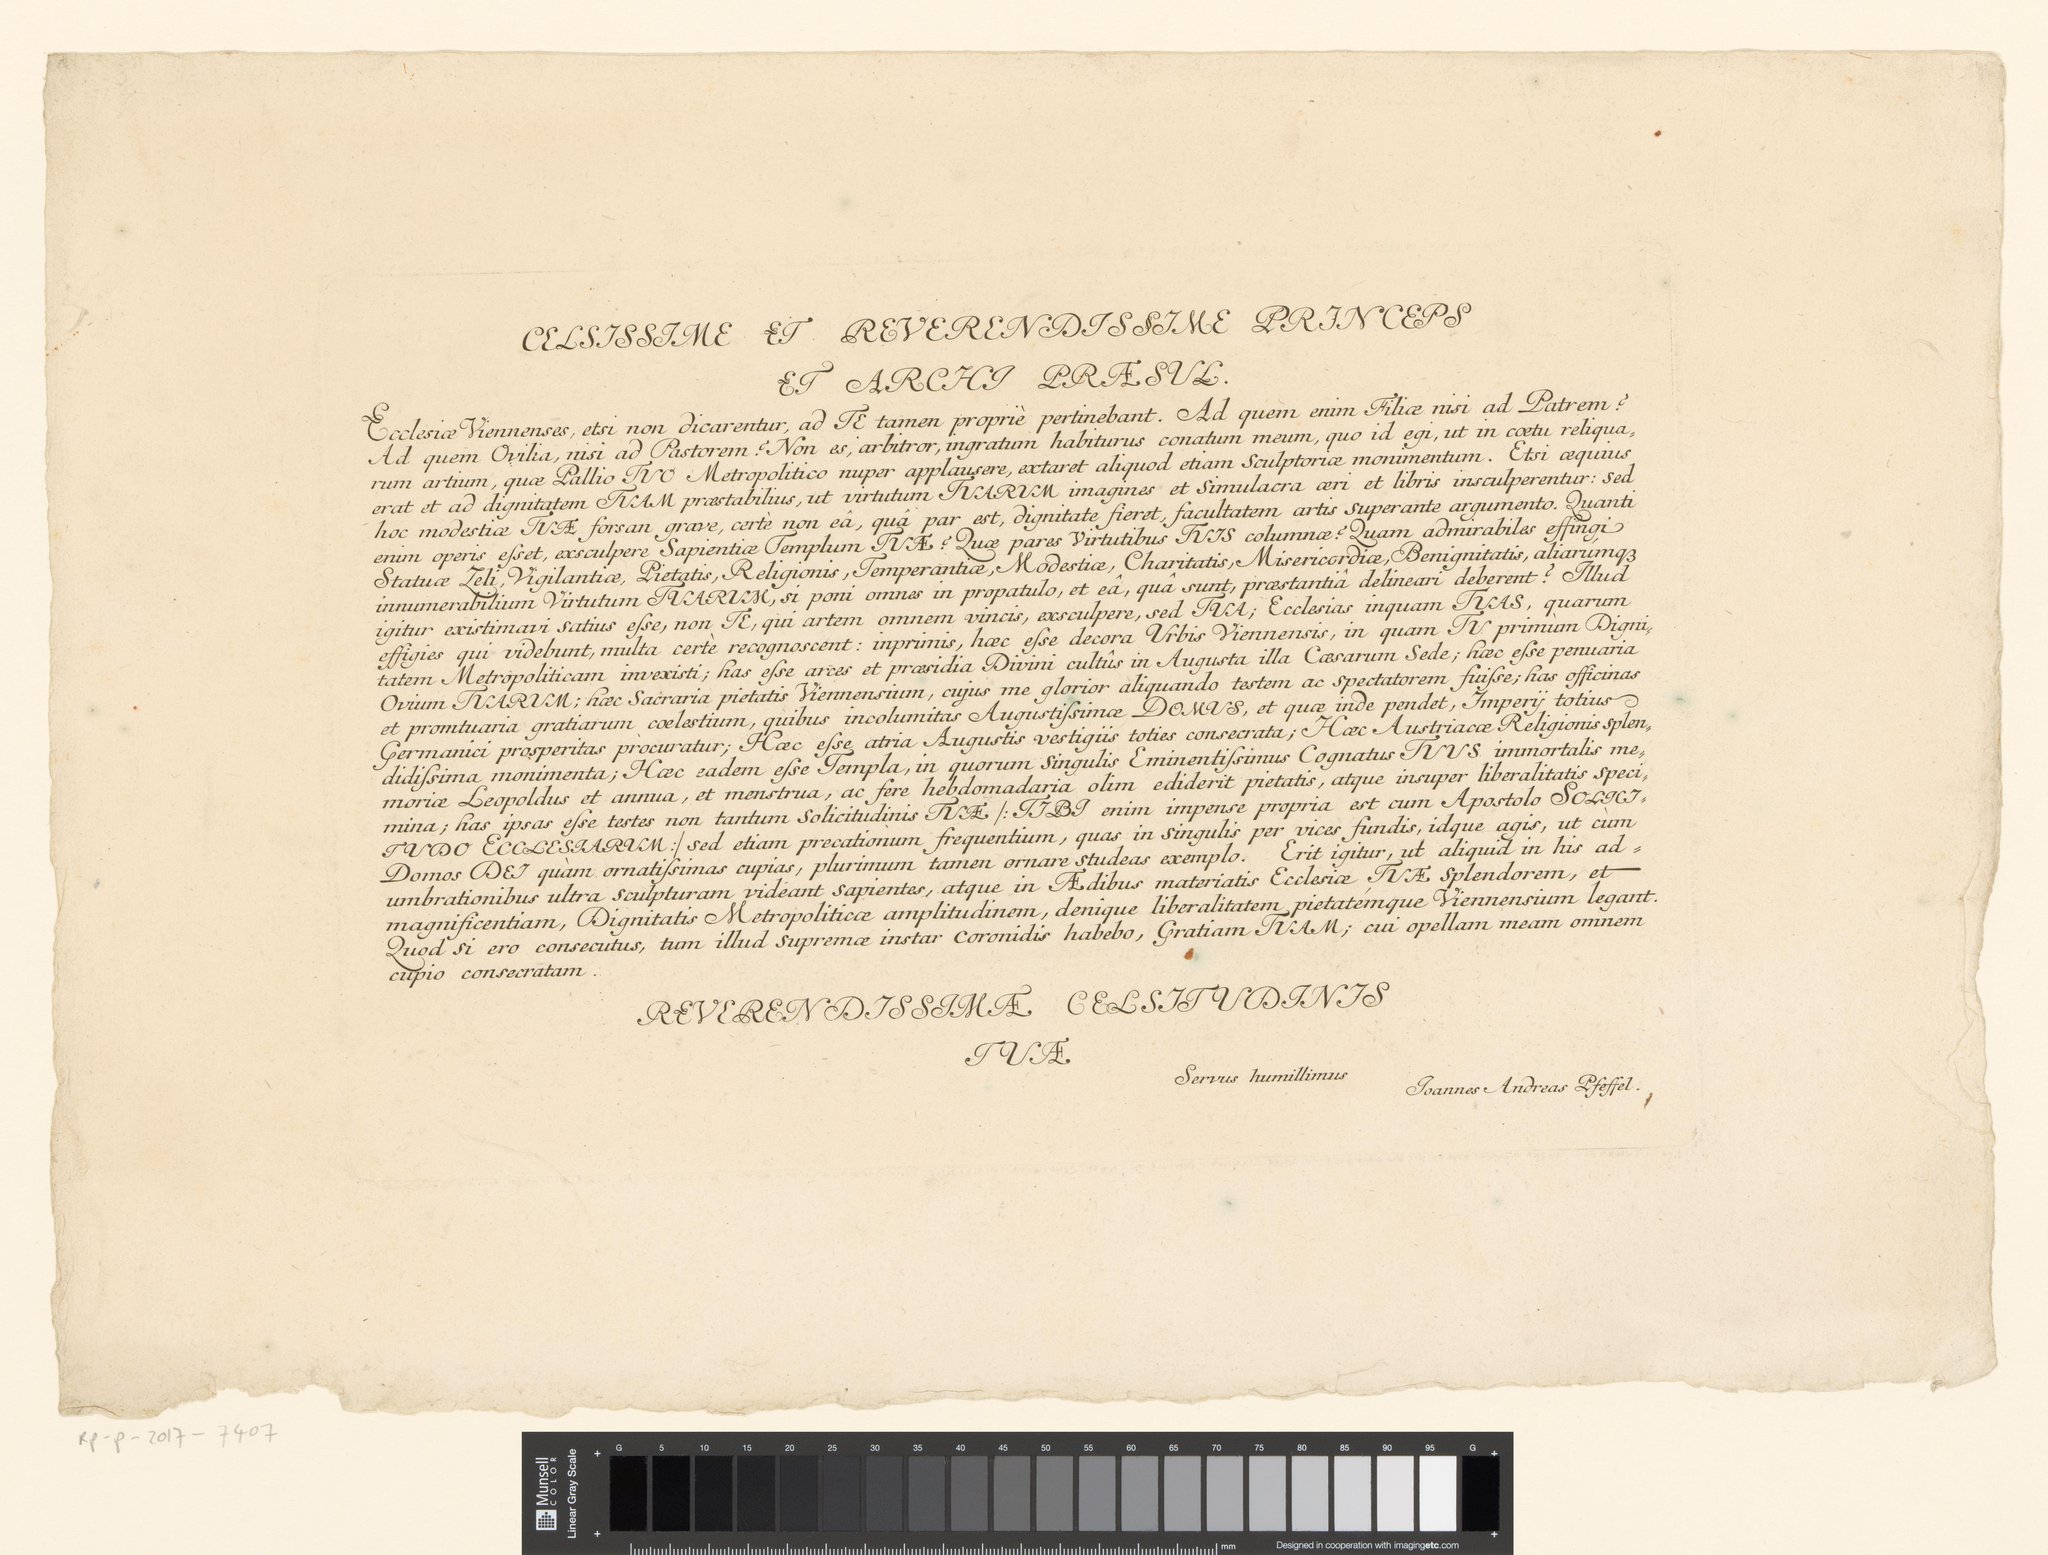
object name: text sheet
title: Wahrhaffte und genaue Abbildung aller Kirchen und Clöster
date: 1724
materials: paper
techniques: engraving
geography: augsburg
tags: title-page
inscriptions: collector's mark: Lugt 2228